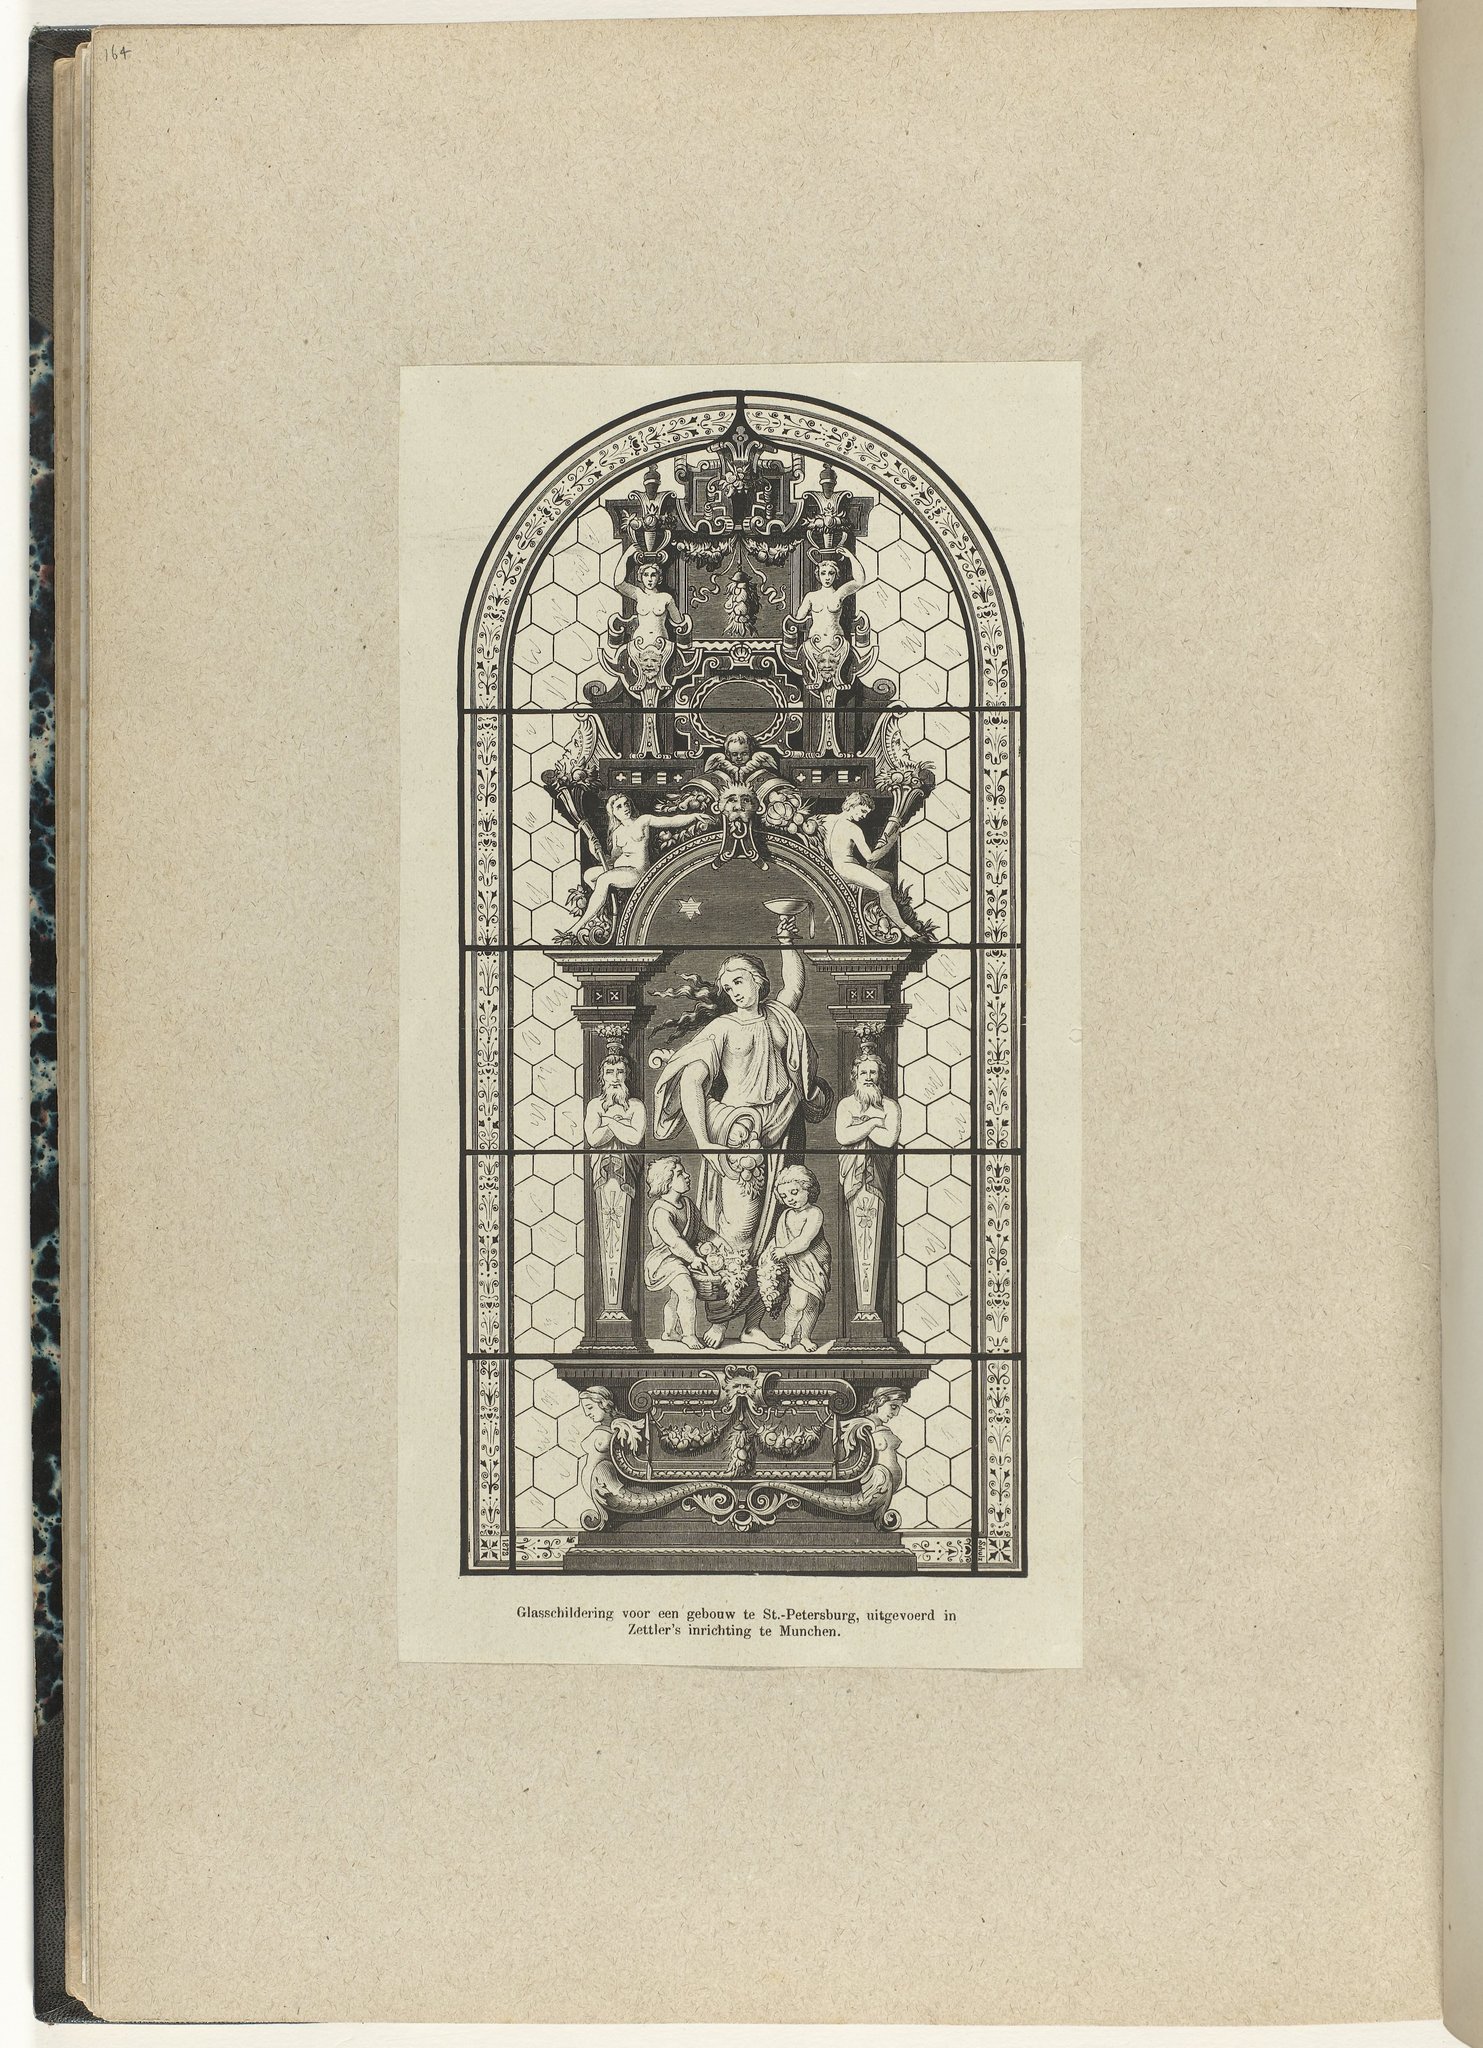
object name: print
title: Glasschildering voor een gebouw te St.-Petersburg (...)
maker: Anonymous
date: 1866-1900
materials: paper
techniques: engraving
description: Midden onder staat een vrouw met een hoorn des overvloeds onder de arm naast twee putti. Aan weerskanten van hen staat een herme.